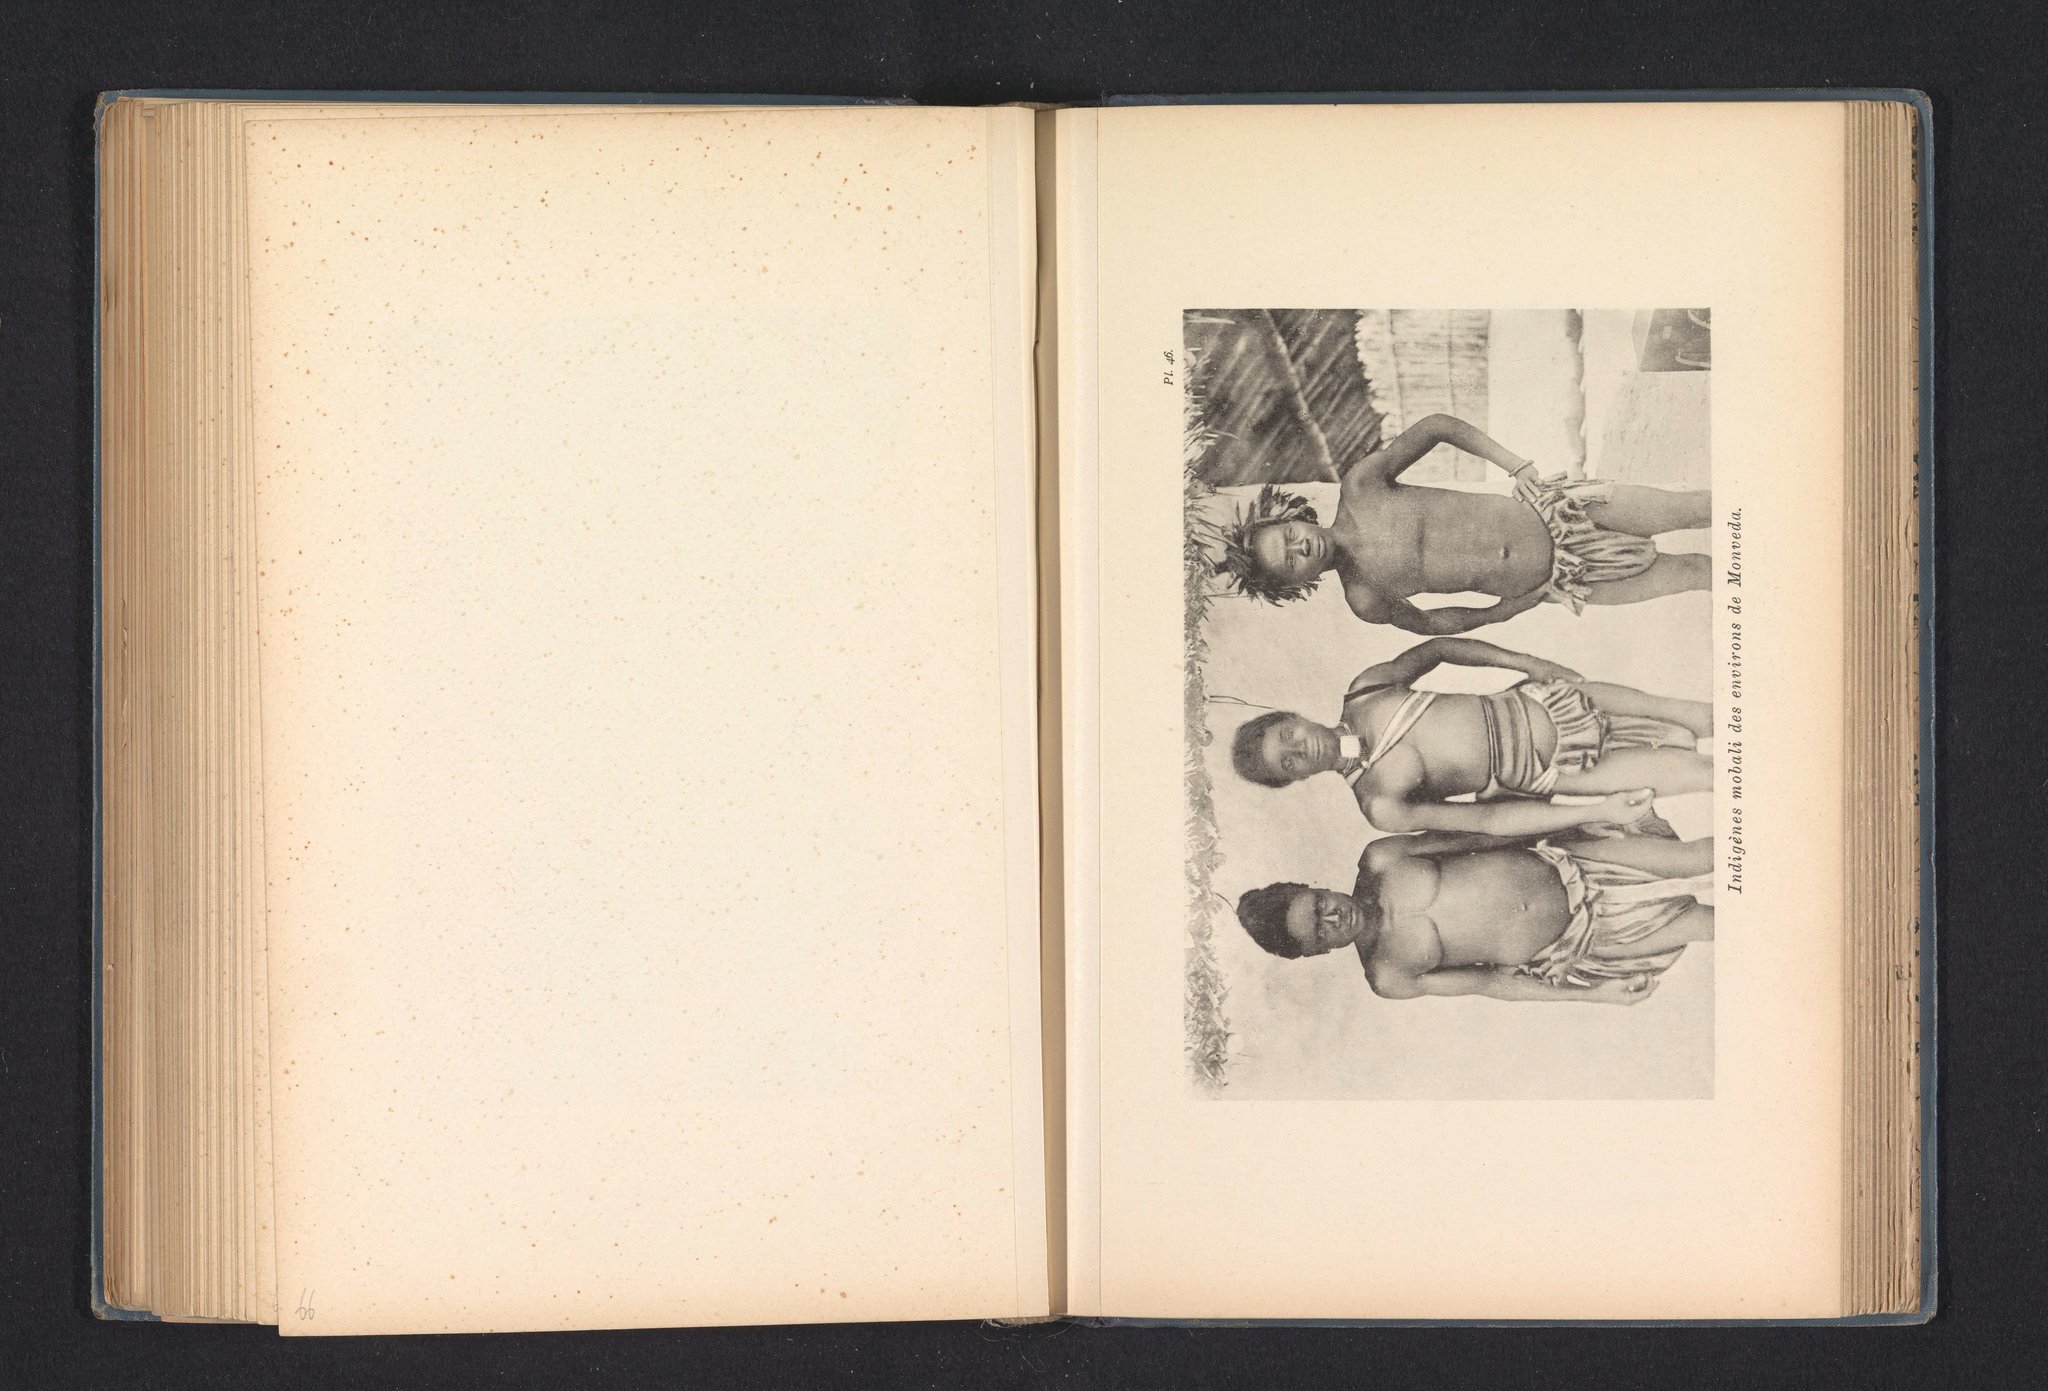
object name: photomechanical print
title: Portret van drie mannen van de Mobali nabij Monveda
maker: franz thonner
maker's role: botanicus, ontdekkingsreiziger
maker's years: 1863-1928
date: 1896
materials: paper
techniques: photograph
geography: dresden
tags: adult man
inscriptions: number: ‘Pl. 46.’